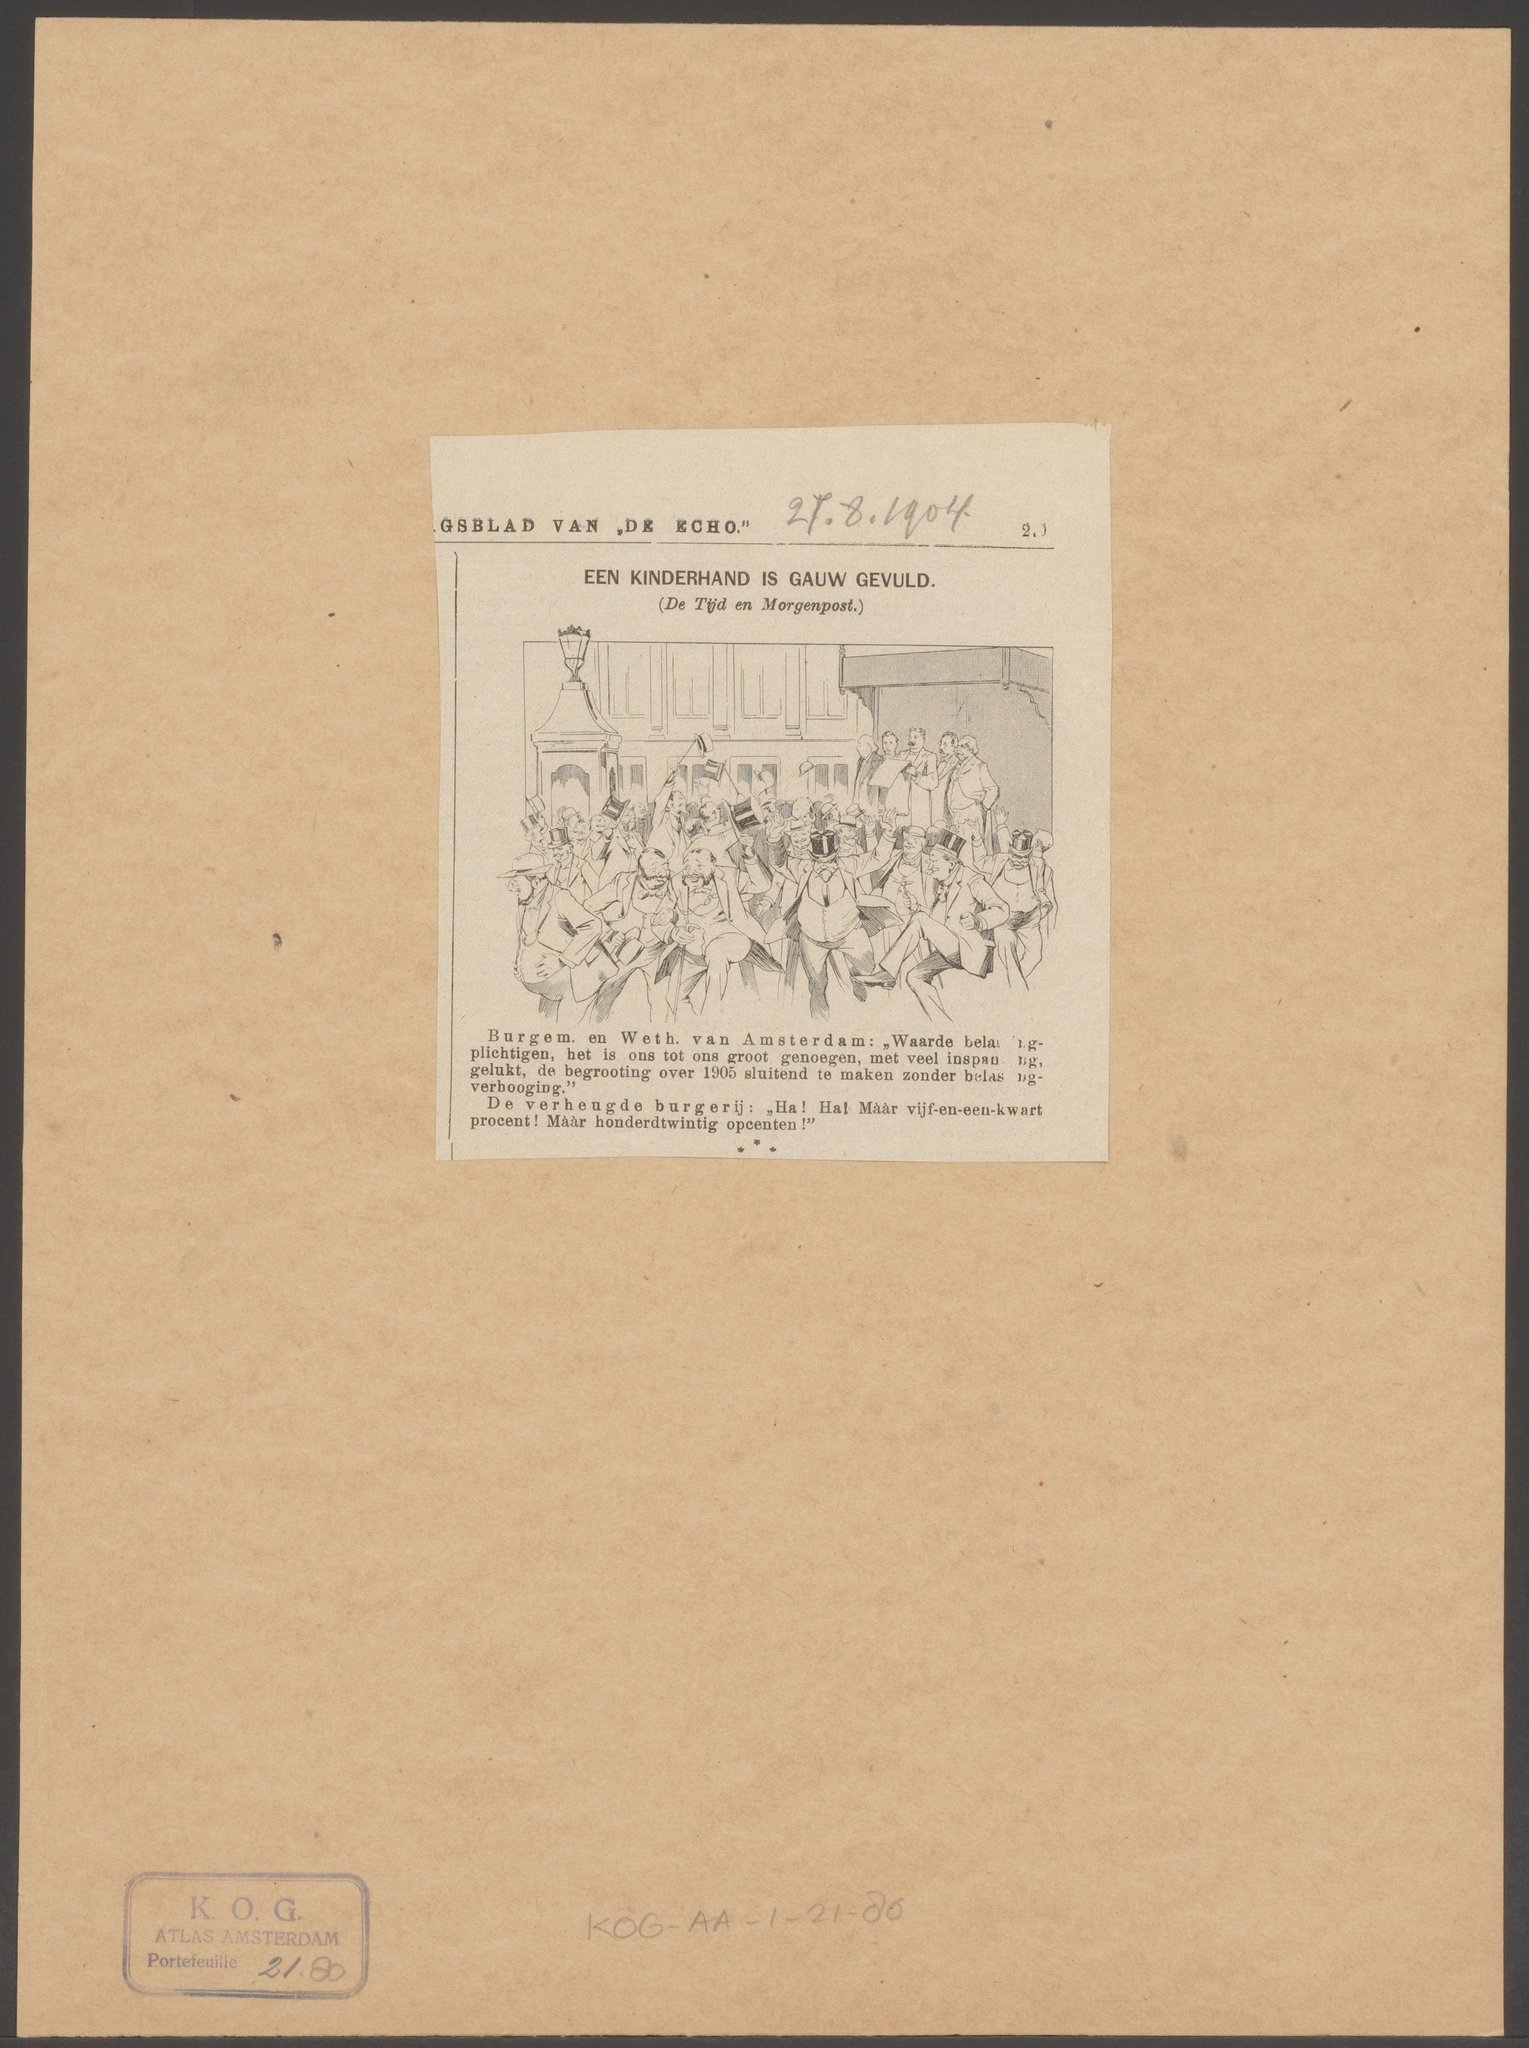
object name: photomechanical print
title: Een kinderhand is gauw gevuld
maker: Anonymous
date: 1904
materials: paper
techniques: letterpress printing, line block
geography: netherlands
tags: politician, e.g. party leader, taxes and financial administration, political caricatures and satires, amsterdam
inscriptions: collector's mark: Lugt 1641b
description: Burgemeester en wethouders van Amsterdam presenterend voor de feestvierende burgerij. Onderwerpsrubriek binnen de Atlas Amsterdam: Financiën.